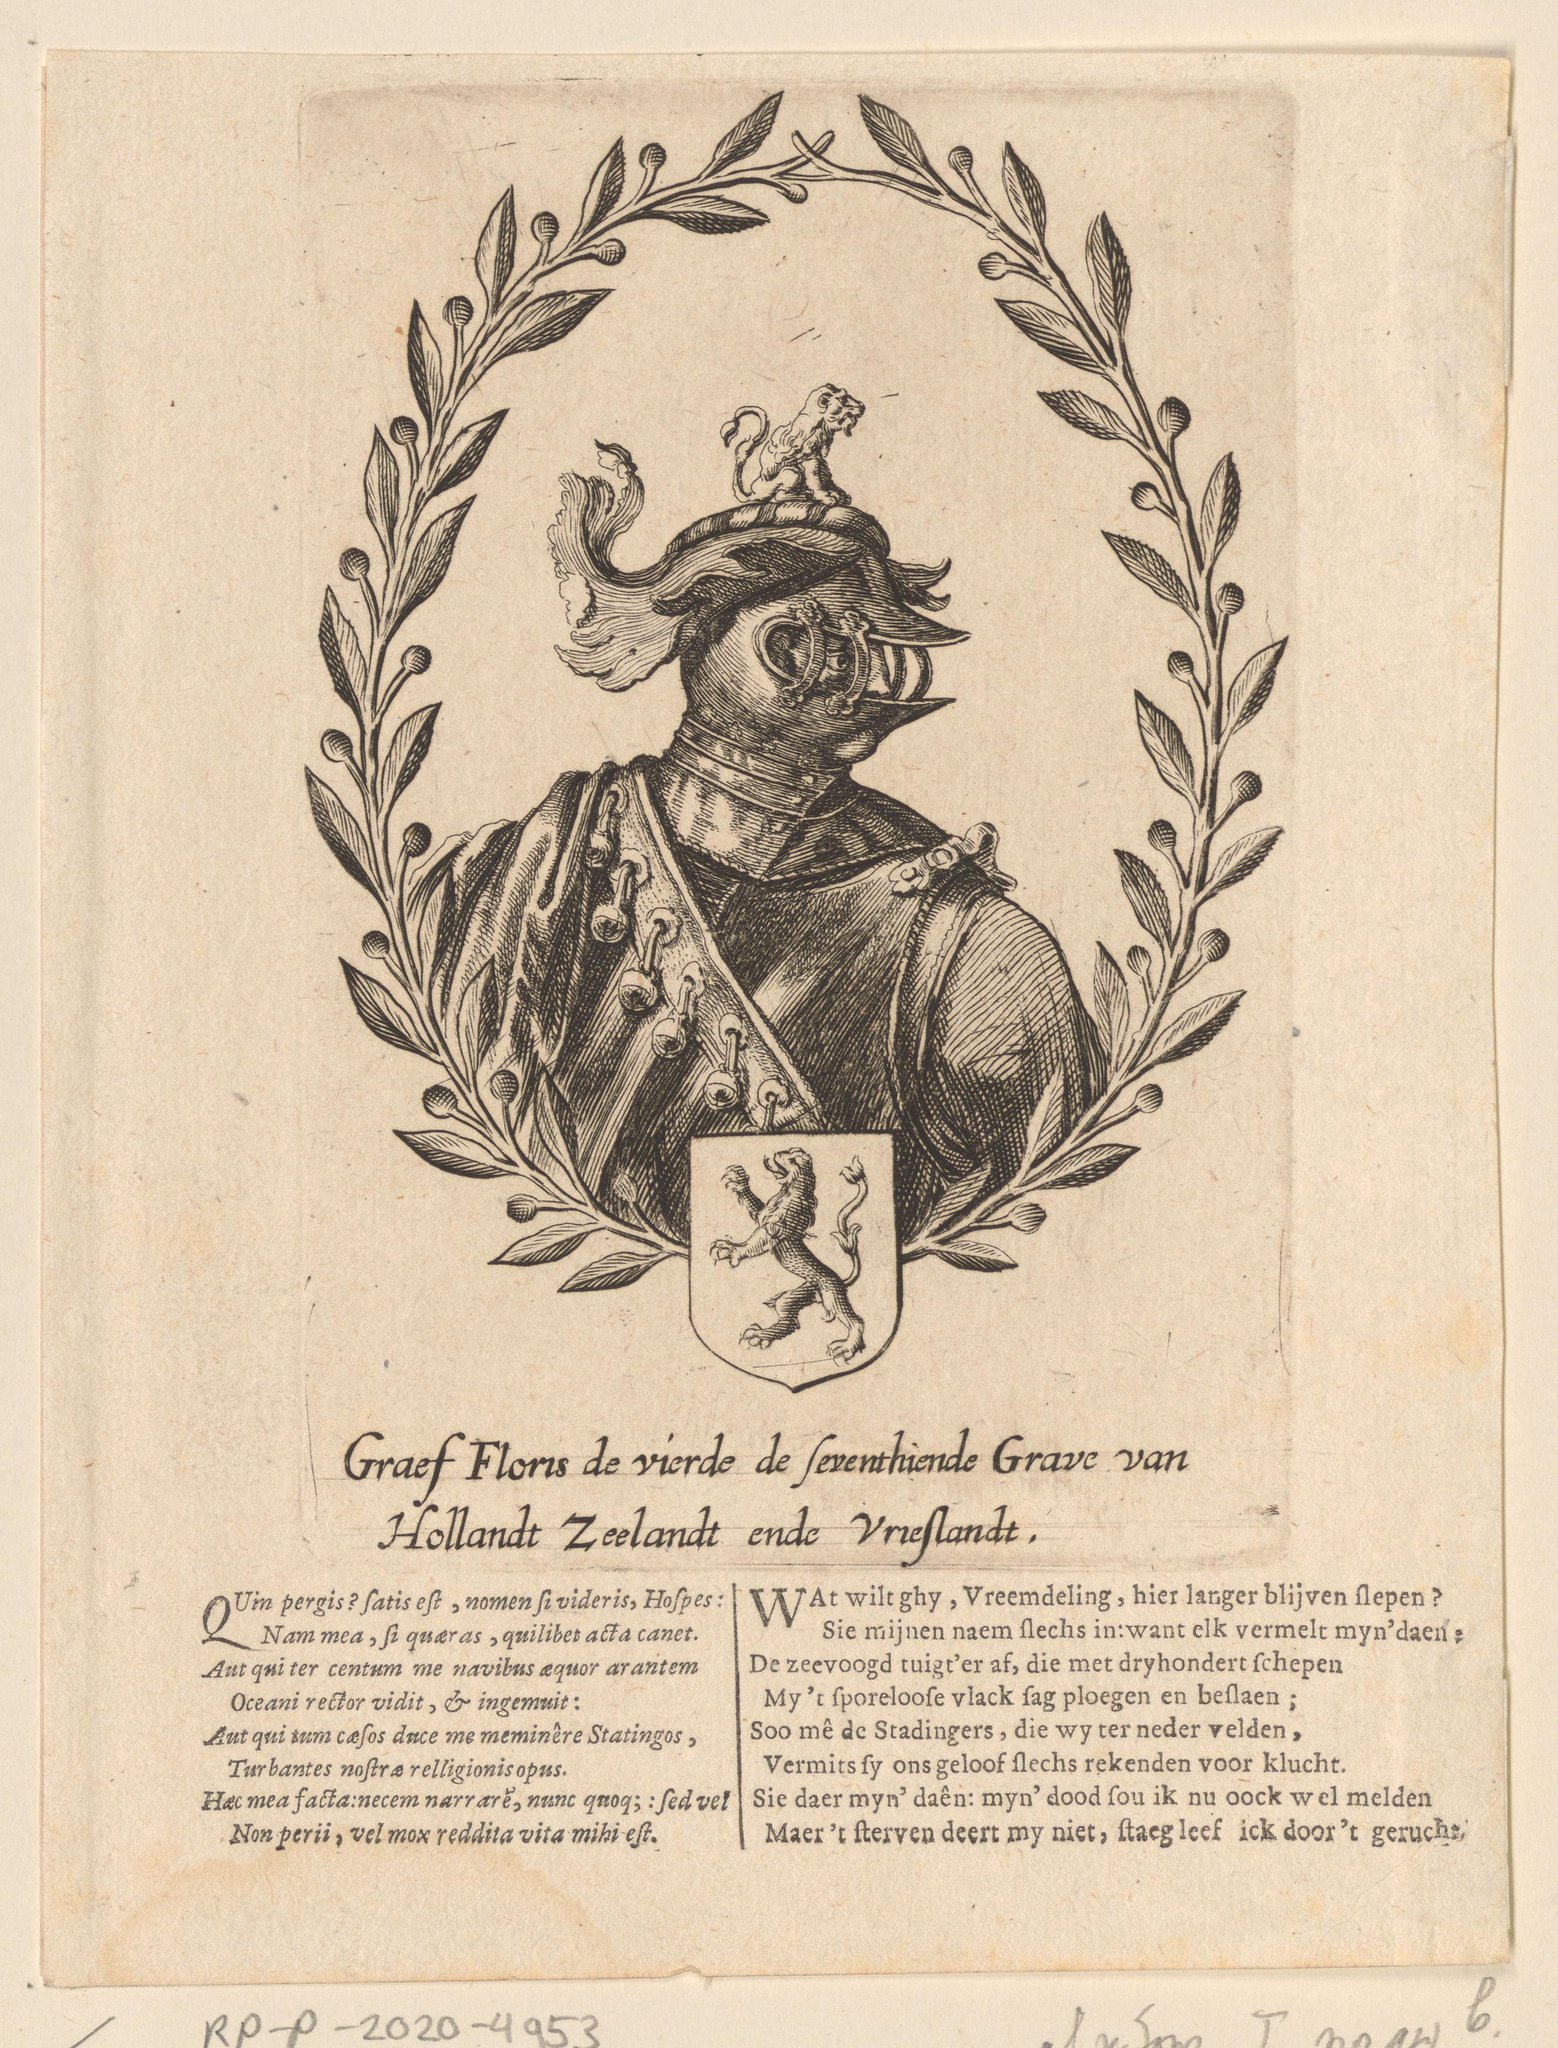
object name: book illustration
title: Portret van Floris IV, graaf van Holland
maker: Anonymous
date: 1678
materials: paper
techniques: engraving, etching, letterpress printing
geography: northern netherlands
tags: floris iv (graaf van holland), coat of arms (as symbol of the state, etc.), armour, historical persons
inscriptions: collector's mark: Lugt 964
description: Prent waarschijnlijk uit: Scriverius, Petrus. Hollandsche, Zeelandsche ende Vriesche Chronyck (...). Den Haag: Johann Veely en Jasper Doll, 1678. Eerdere staat gebruikt in 'Oude Hollandsche Geschiedenissen (...)' van Wachtendorp, 1645.